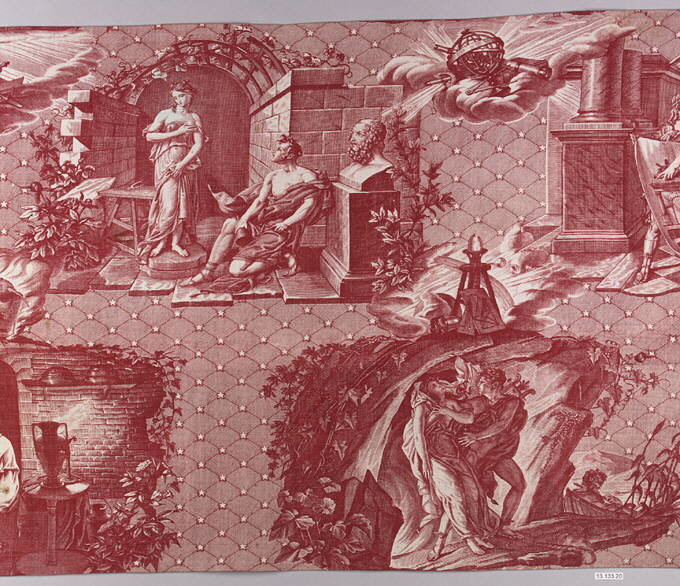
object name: furnishing textile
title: The Arts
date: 1815-1820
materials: cotton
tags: men,women